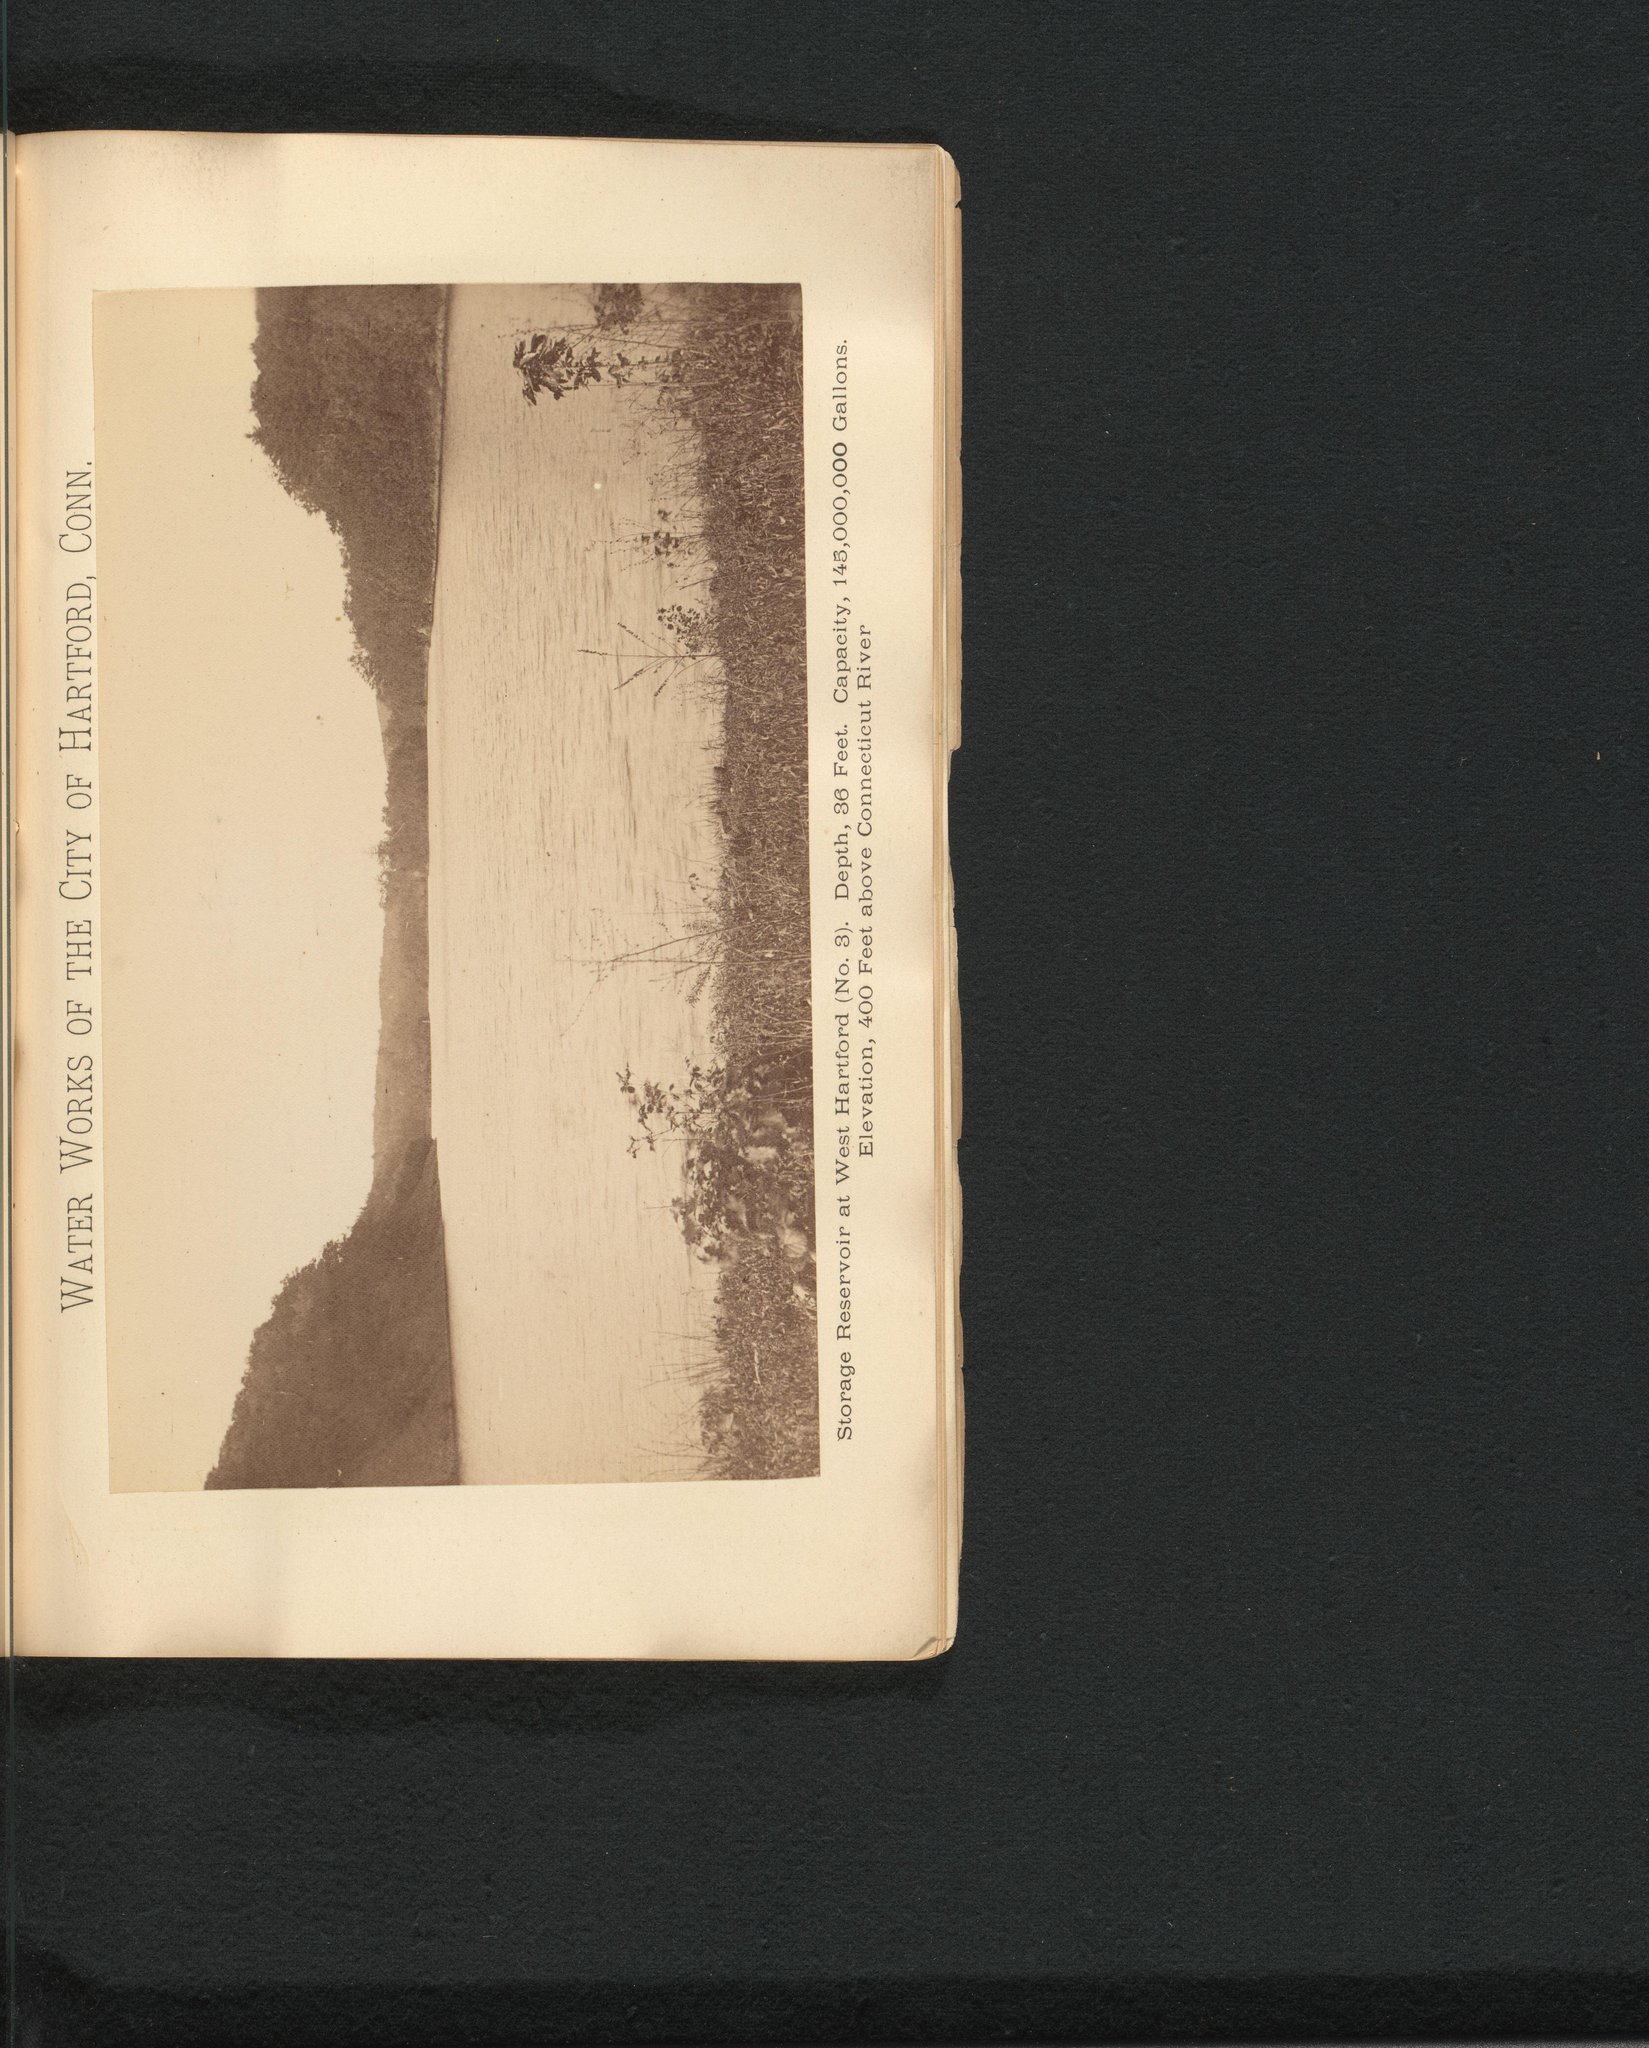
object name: photograph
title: Water works of the city of Hartford, Conn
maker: Anonymous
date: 1883-1884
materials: photographic support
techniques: albumen print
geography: connecticut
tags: water course